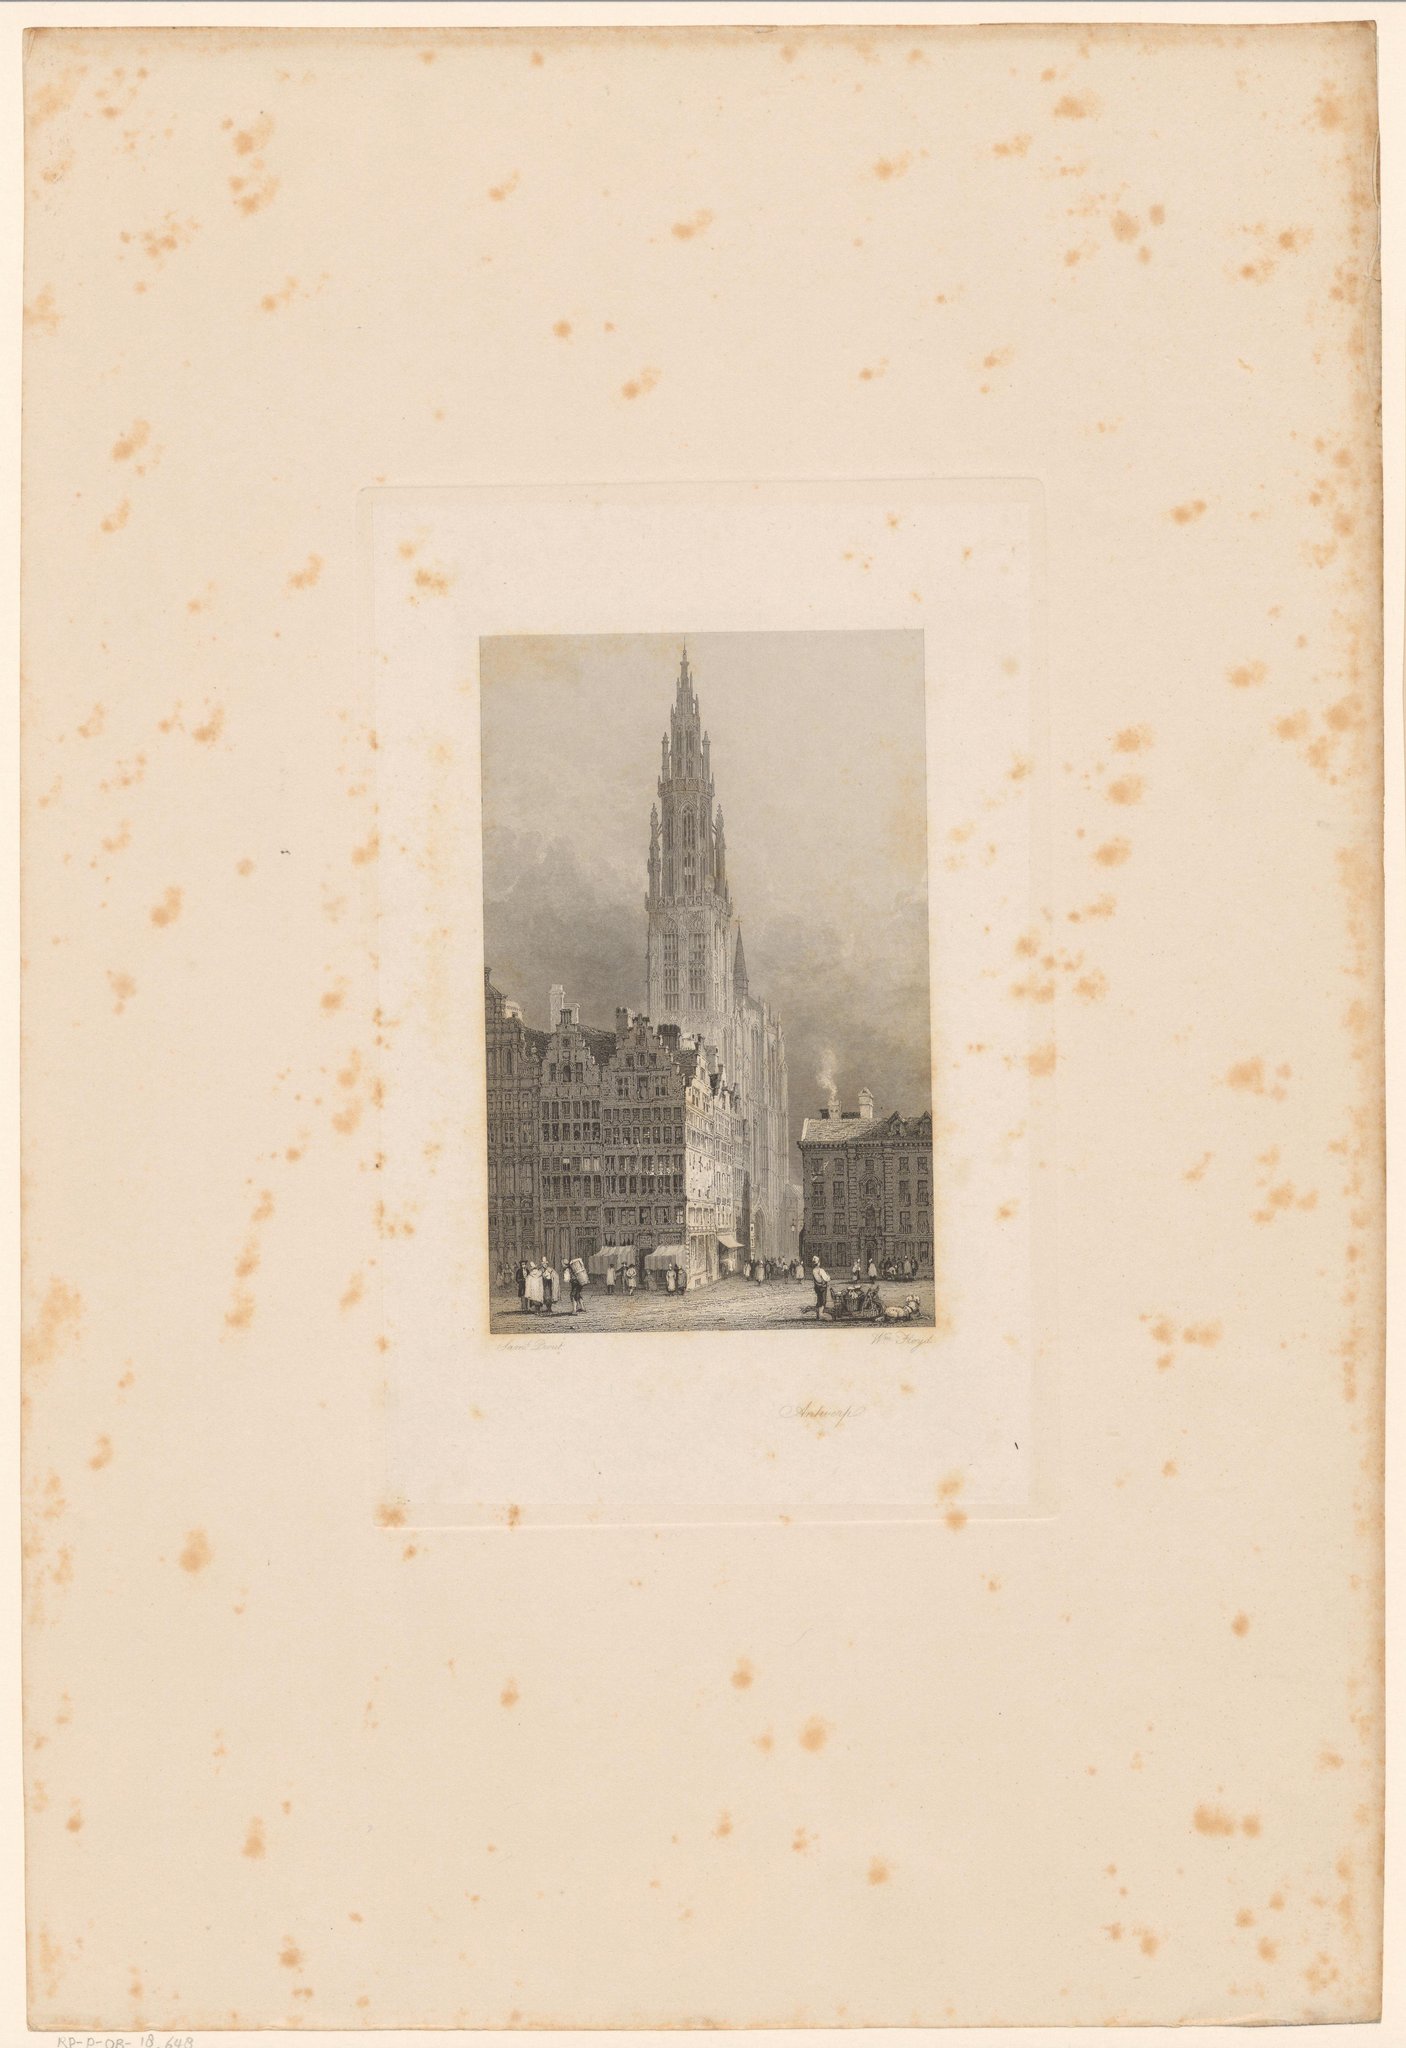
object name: print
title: Antwerp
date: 1836-1877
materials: paper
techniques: engraving, etching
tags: roman catholic church, city-view in general; 'veduta' (+ city(-scape) with figures, staffage), antwerp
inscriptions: collector's mark: Lugt 2228